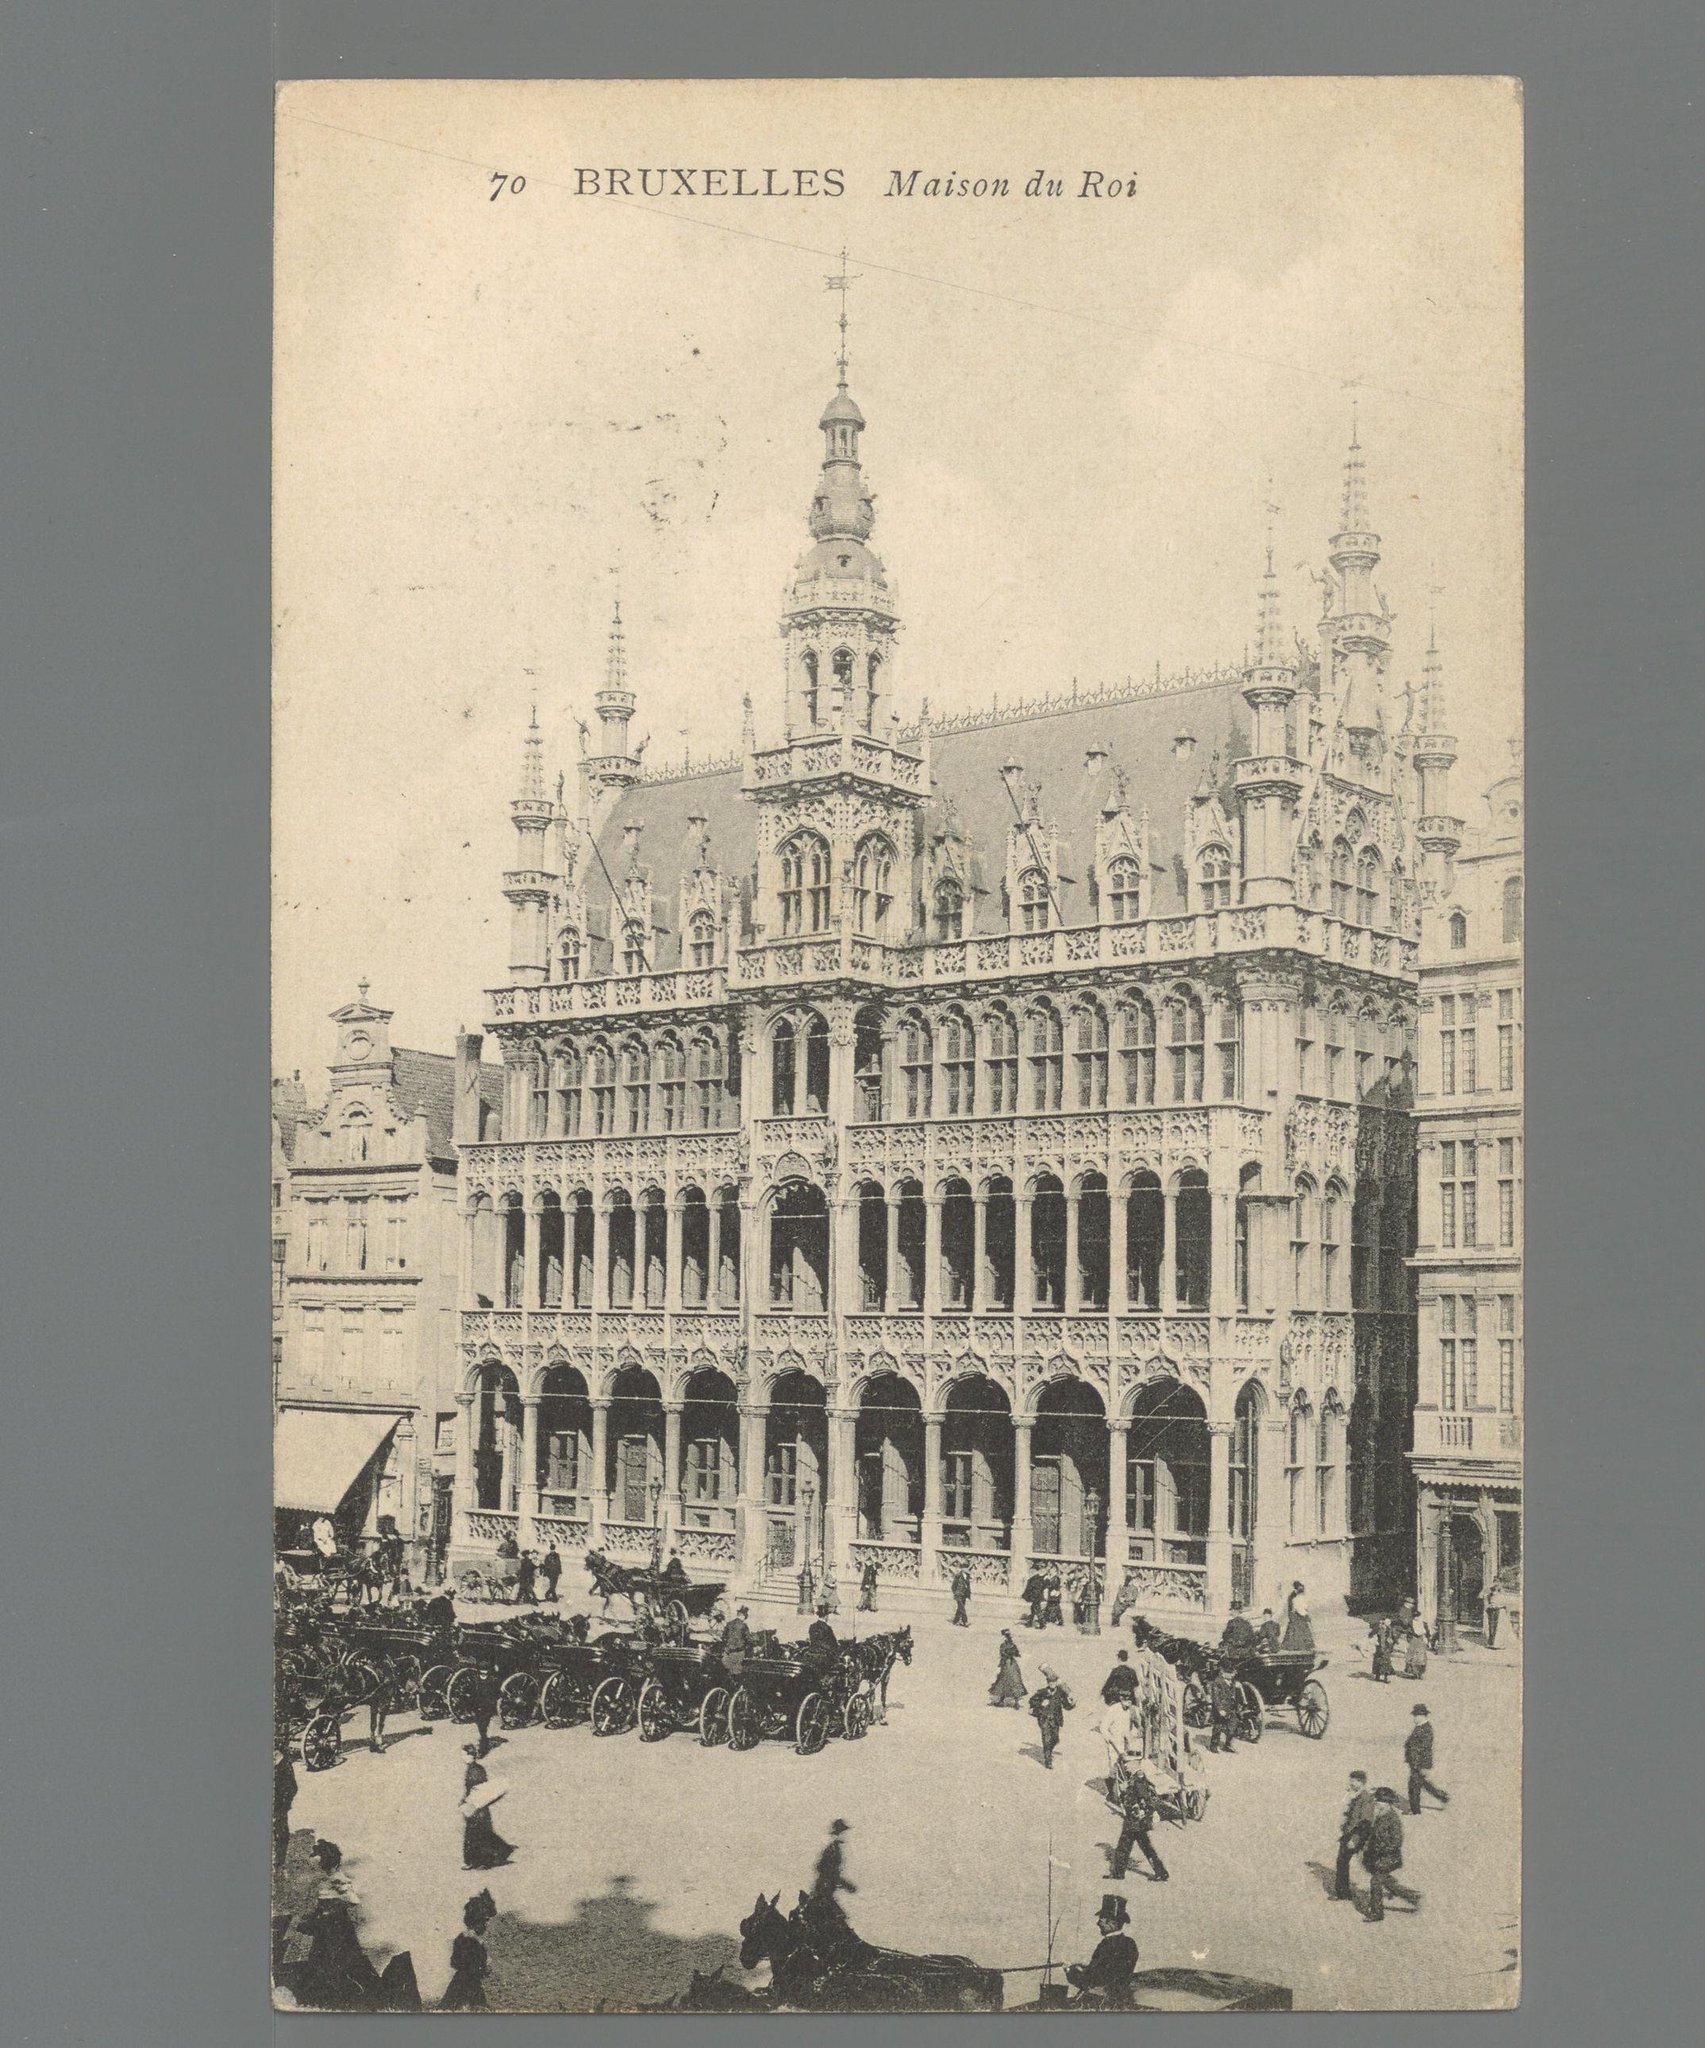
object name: photomechanical print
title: Bruxelles. Maison du Roi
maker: Anonymous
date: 1906-1907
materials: cardboard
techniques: photograph, writing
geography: brussels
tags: square, place, circus, etc., city-view, and landscape with man-made constructions (+ city(-scape) with figures, staffage), edifice, e.g.: public building, department store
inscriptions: postage stamp